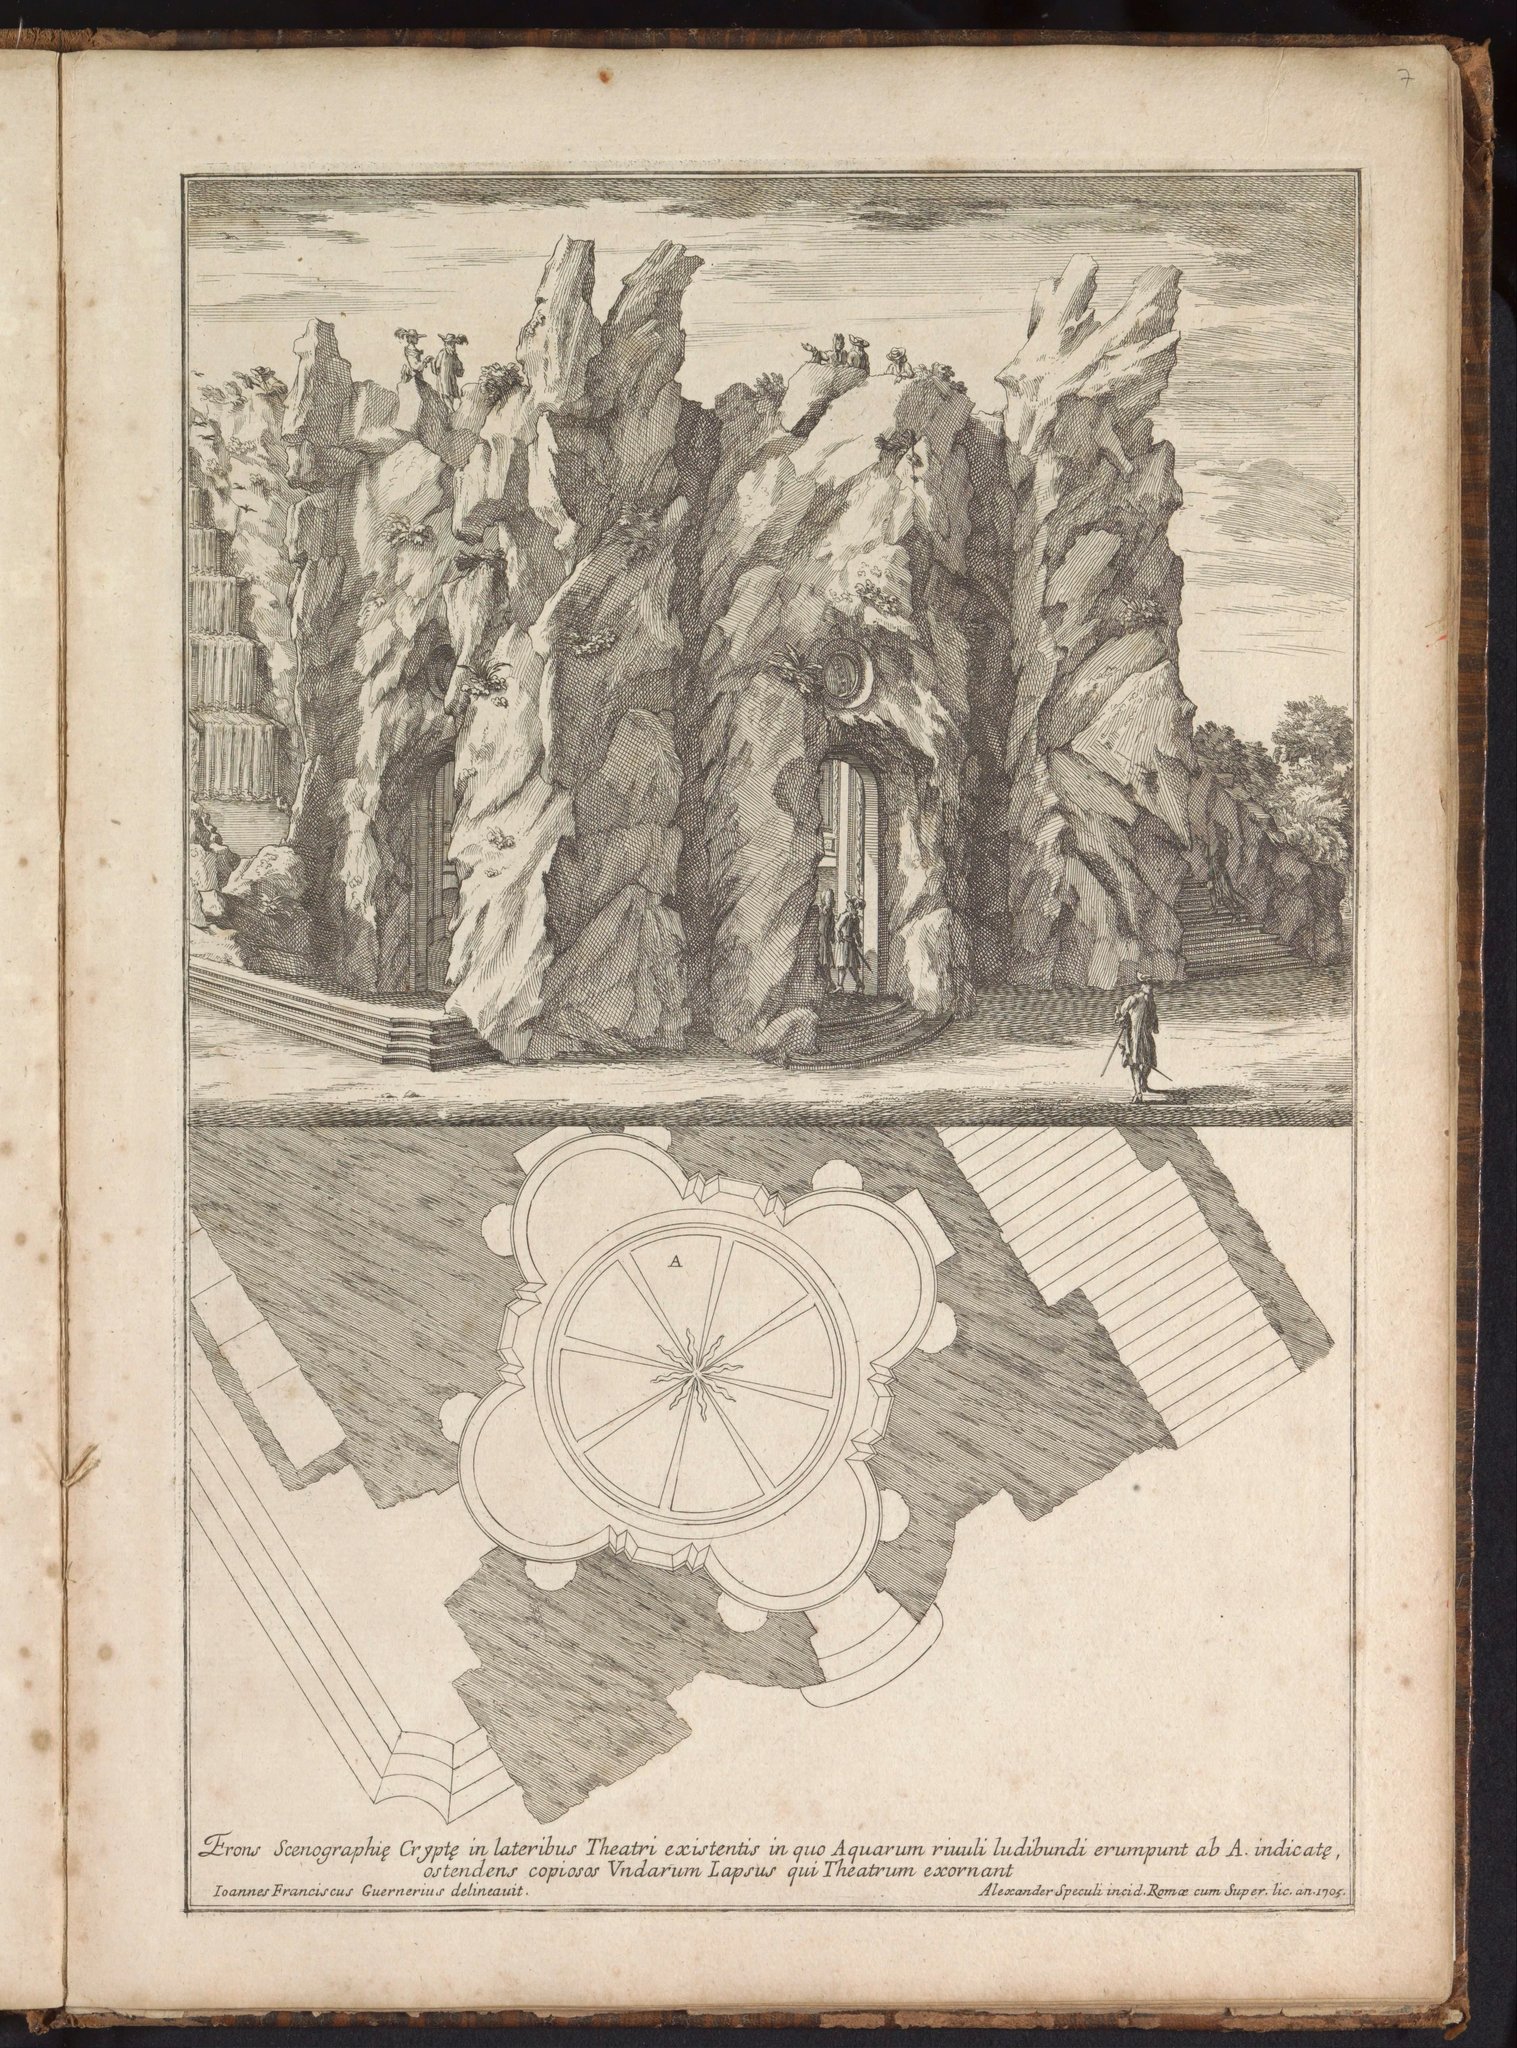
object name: album leaf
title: Disegno del monte situato presso la citta metropolitana di Cassel (...)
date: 1705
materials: paper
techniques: etching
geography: rome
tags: garden fountain, artificial grotto in garden, plan ~ architecture